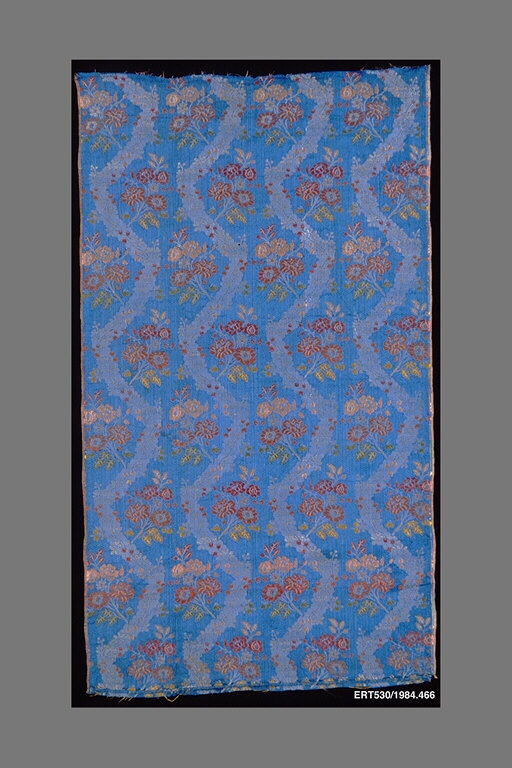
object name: panel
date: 1734-1766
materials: silk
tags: flowers